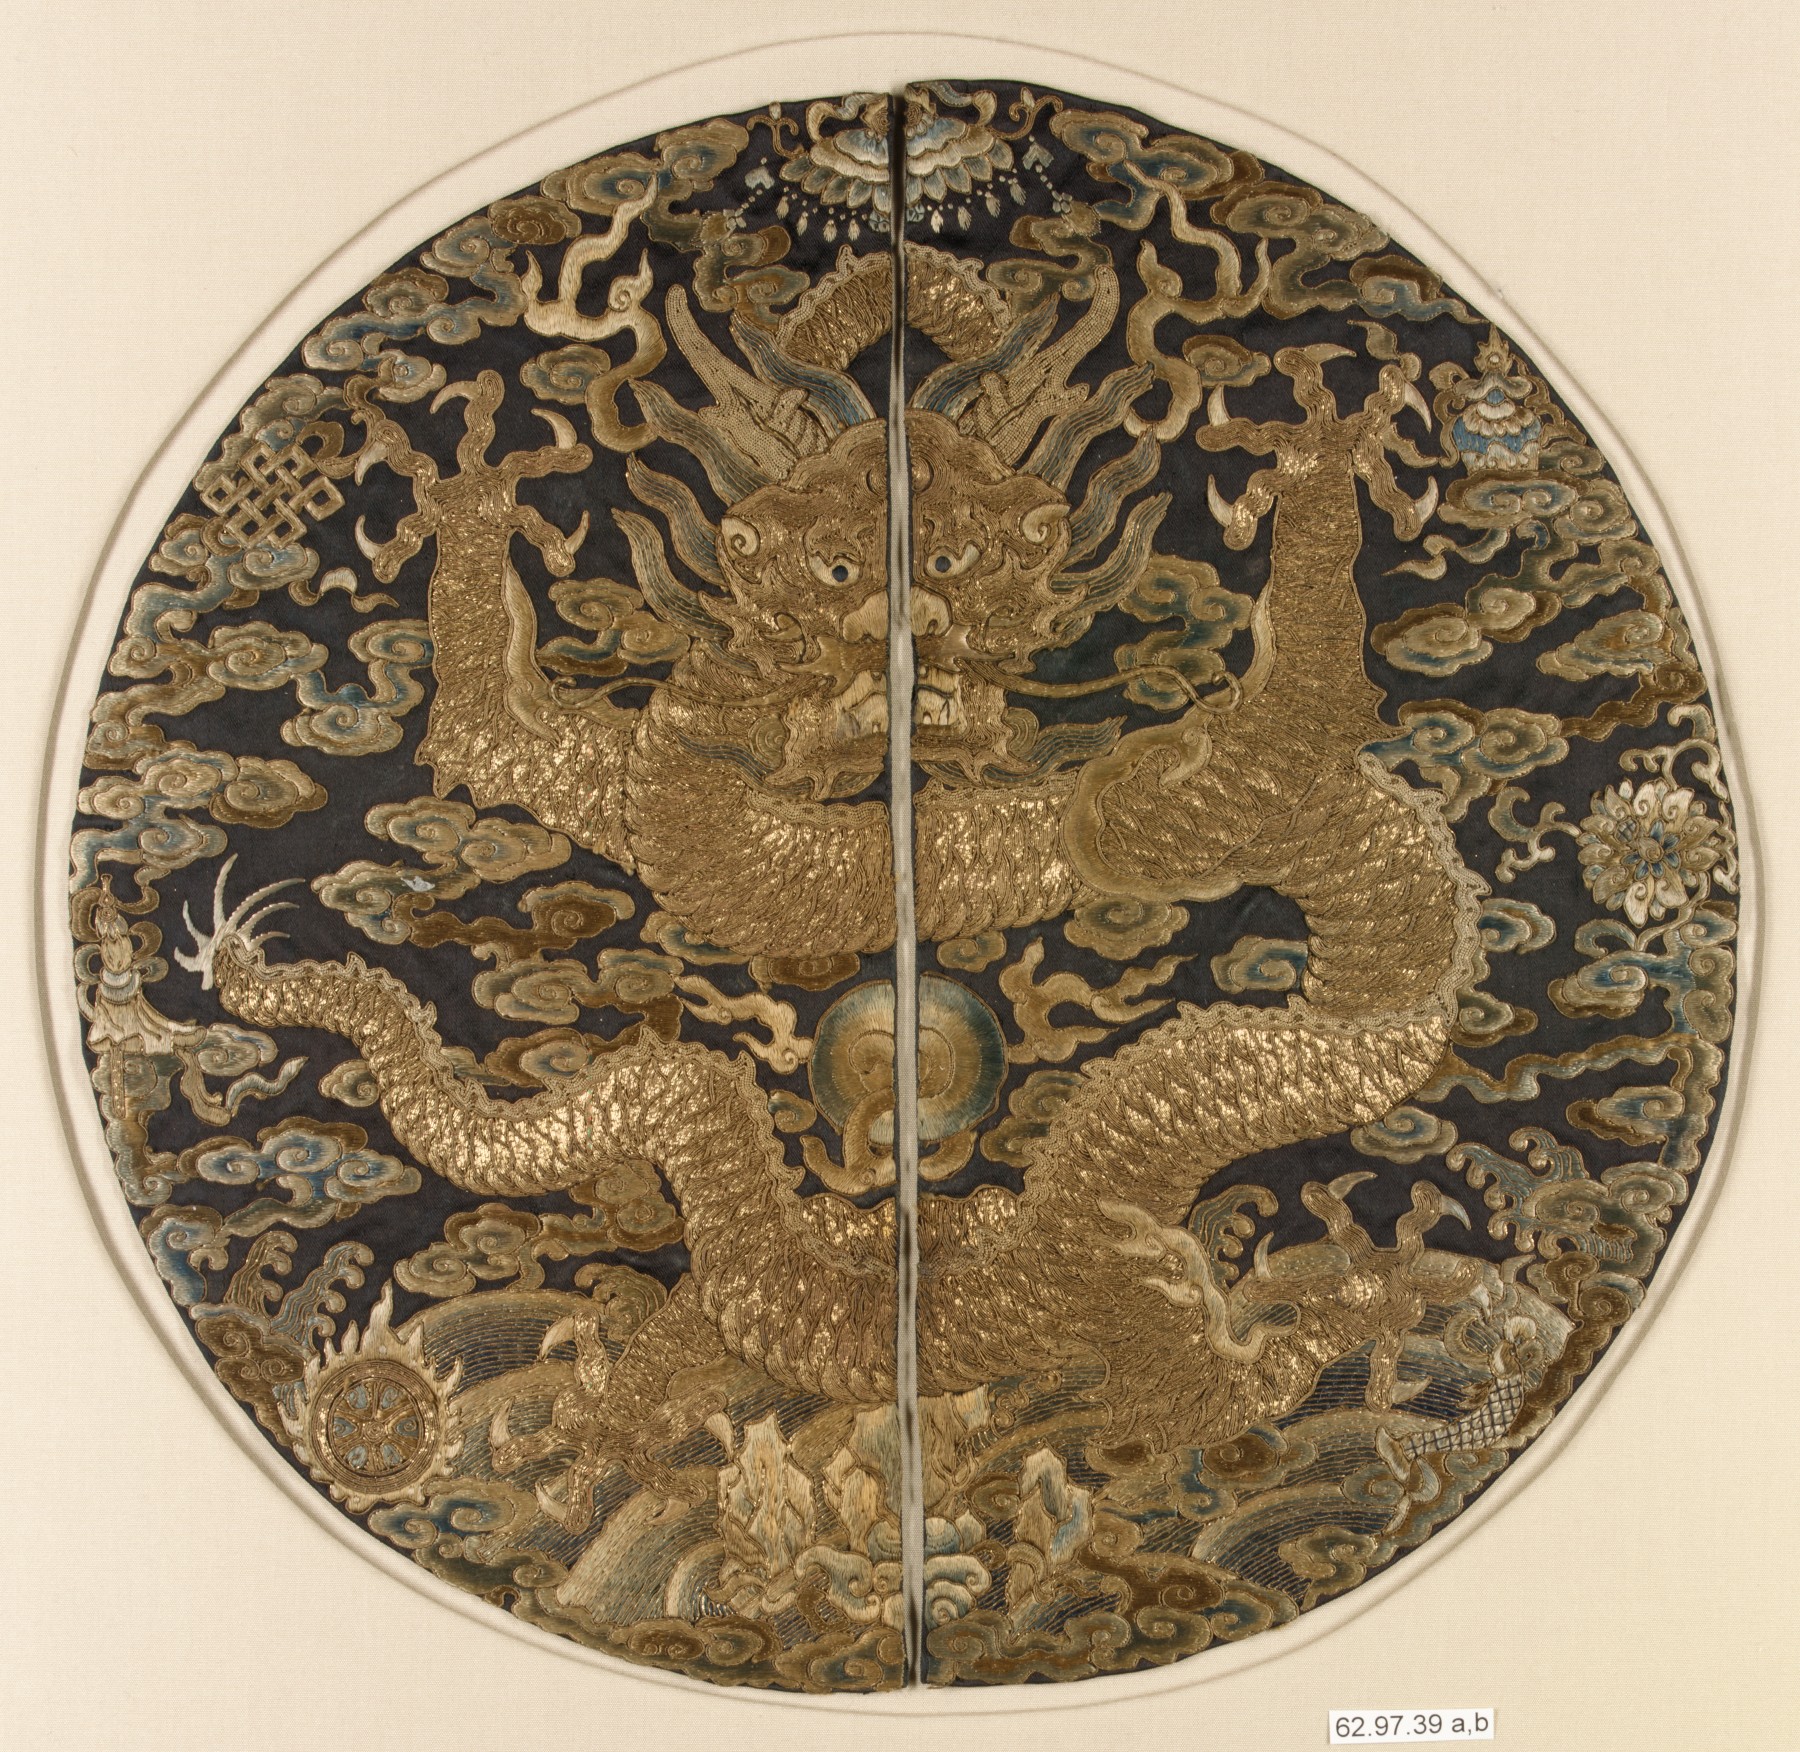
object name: roundel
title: Dragon Roundel from a Ceremonial Garment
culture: chinese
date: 1701-1733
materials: metal thread, silk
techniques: embroidery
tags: dragons